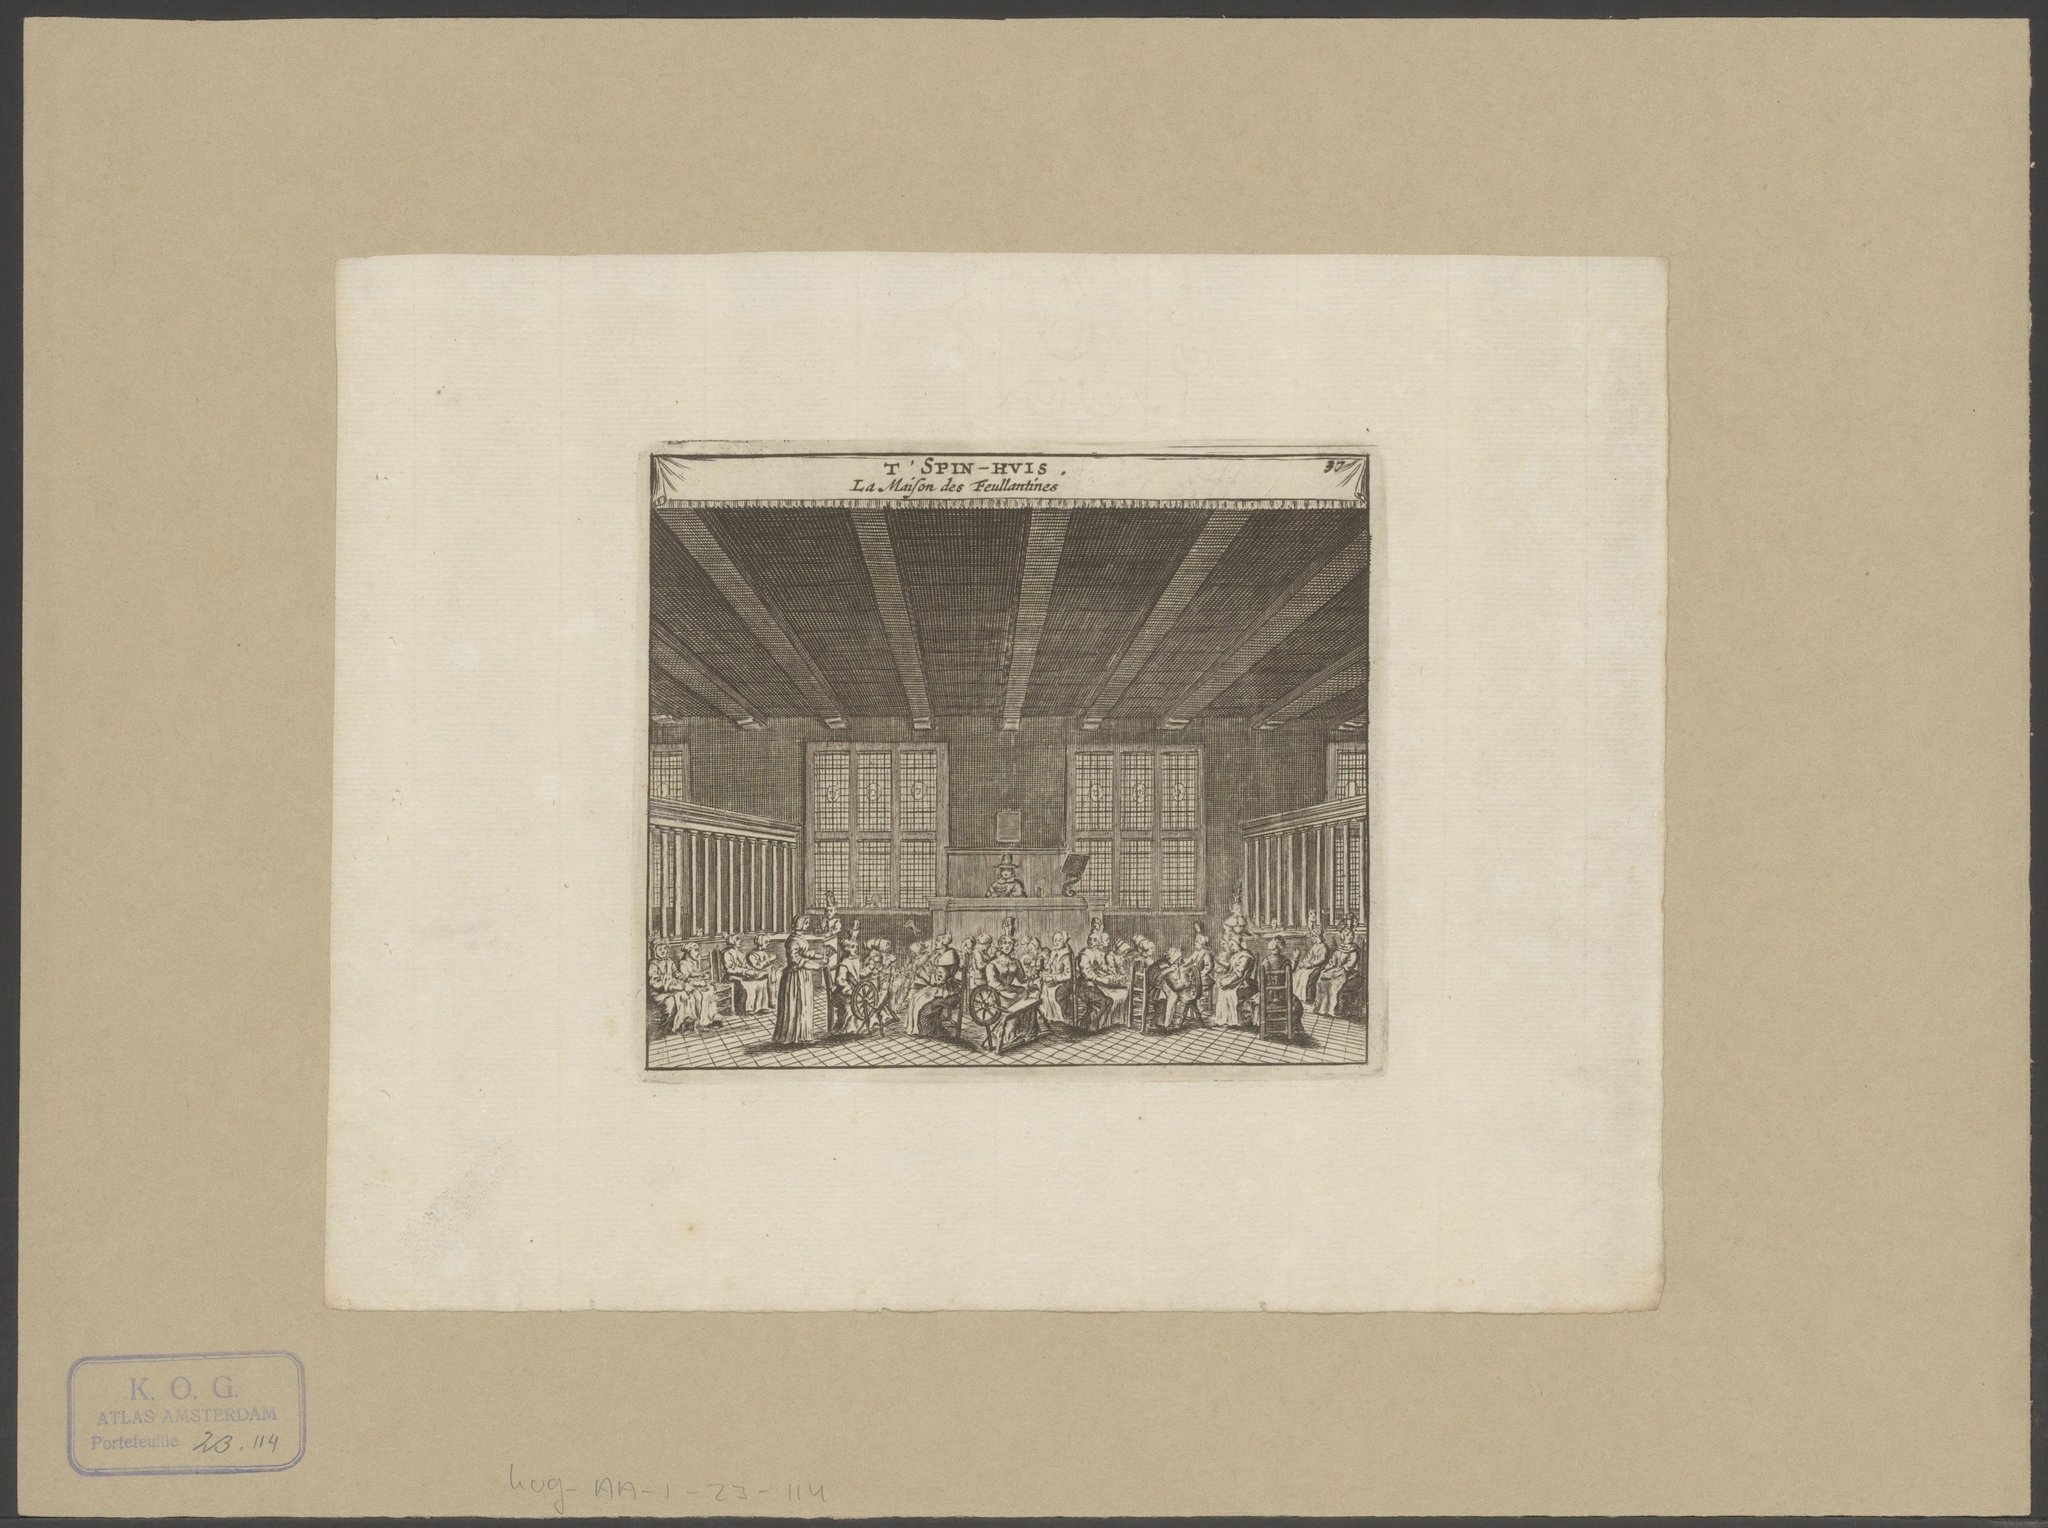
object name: print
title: t' Spin-huis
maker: Anonymous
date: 1713-1749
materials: paper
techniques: etching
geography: northern netherlands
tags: prison, jail, spinning (manufacture of yarn), workhouse, penal camp, penitentiary, chain gang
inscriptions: collector's mark: Lugt 1641b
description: Huidige staat van prent ook gebruikt in: Beknopte beschryving van alle de voornaamste Gebouwen der wydvermaarde Koopstad Amsterdam (...). Amsterdam: Dirk Schouten, 1713. En in latere publicaties van 1741 en 1749. Eerste bekende staat (zonder nummer en Franse titel) ook gebruikt in: Fockens, Melchior. Beschrijvingh Der wijdt-vermaarde Koop-stadt Amstelredam (…). 3de druk. Amsterdam: Marcus Willemsz. Doornick, 1664. Tweede bekende staat (met toevoeging Franse titel) ook gebruikt in: Domselaer, Tobias en Isaac Commelin. Beschryvinge van Amsterdam (…). 6 dln. Amsterdam: Marcus Willemsz. Doornick, 1665, dl. 4, p. 107.